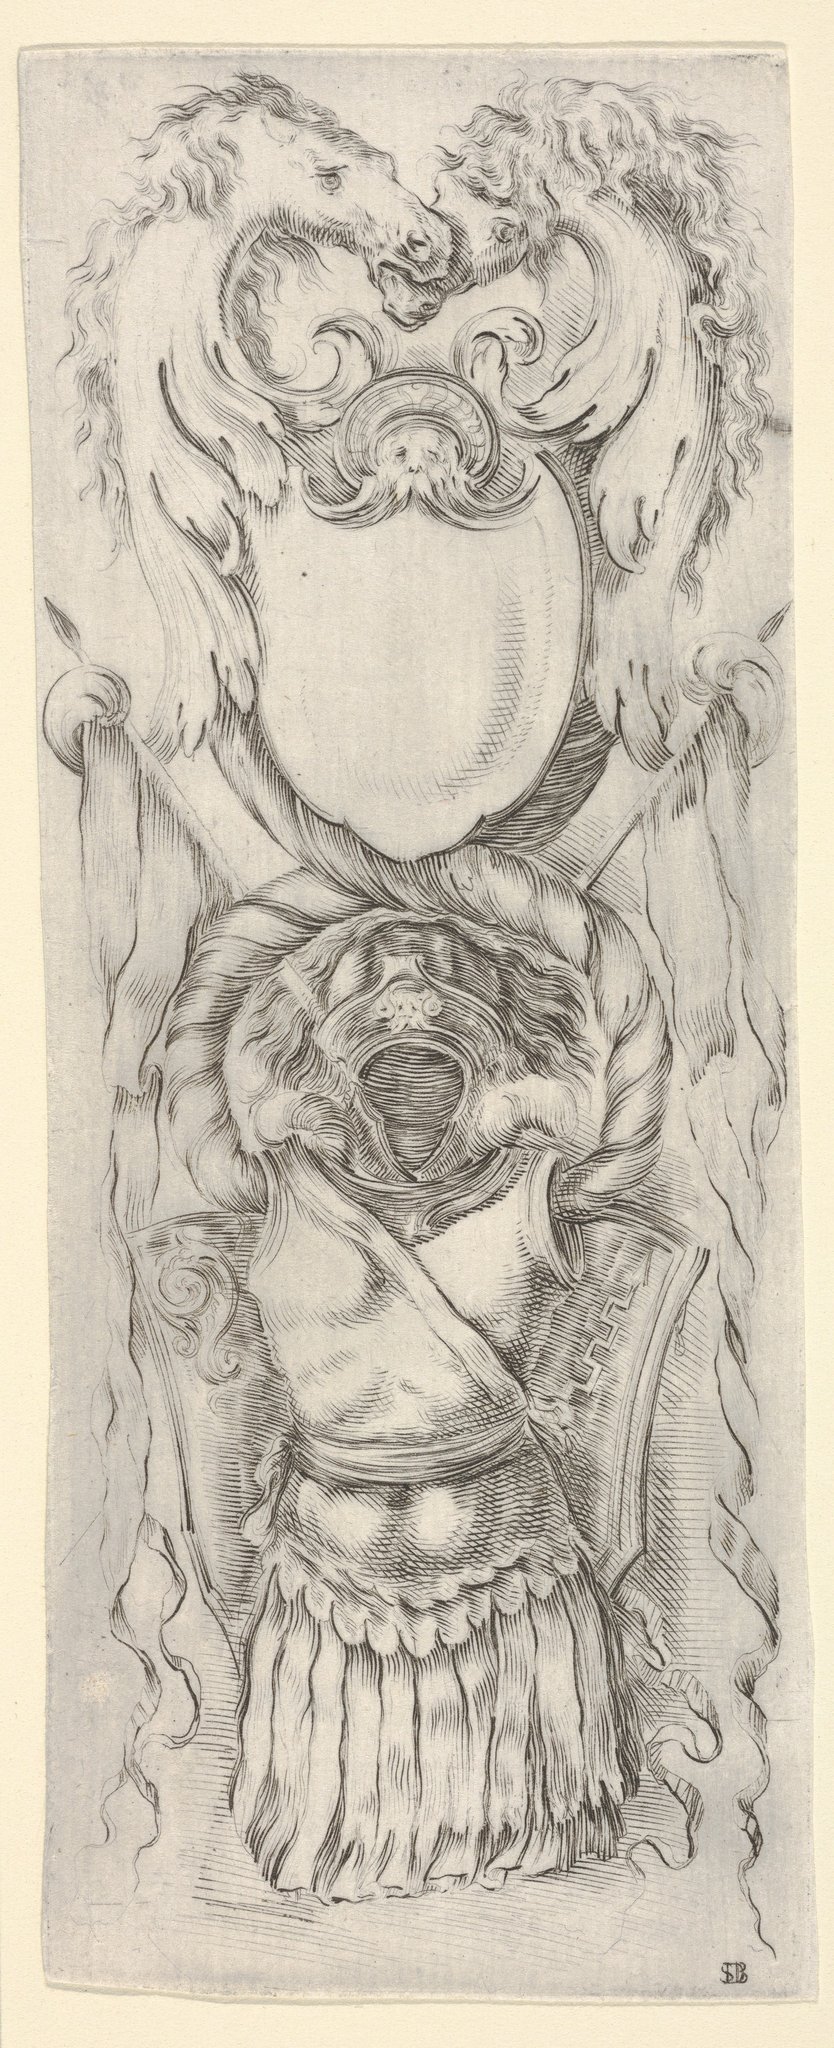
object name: print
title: Vertical Panel with a Cartouche stacked on top of a Cuirass, from "Ornaments or Grotesques" (Ornamenti o Grottesche)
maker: stefano della bella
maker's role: artist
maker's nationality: italian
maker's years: 1610-1664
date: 1650-1656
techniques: etching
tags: armor,cartouches,horses